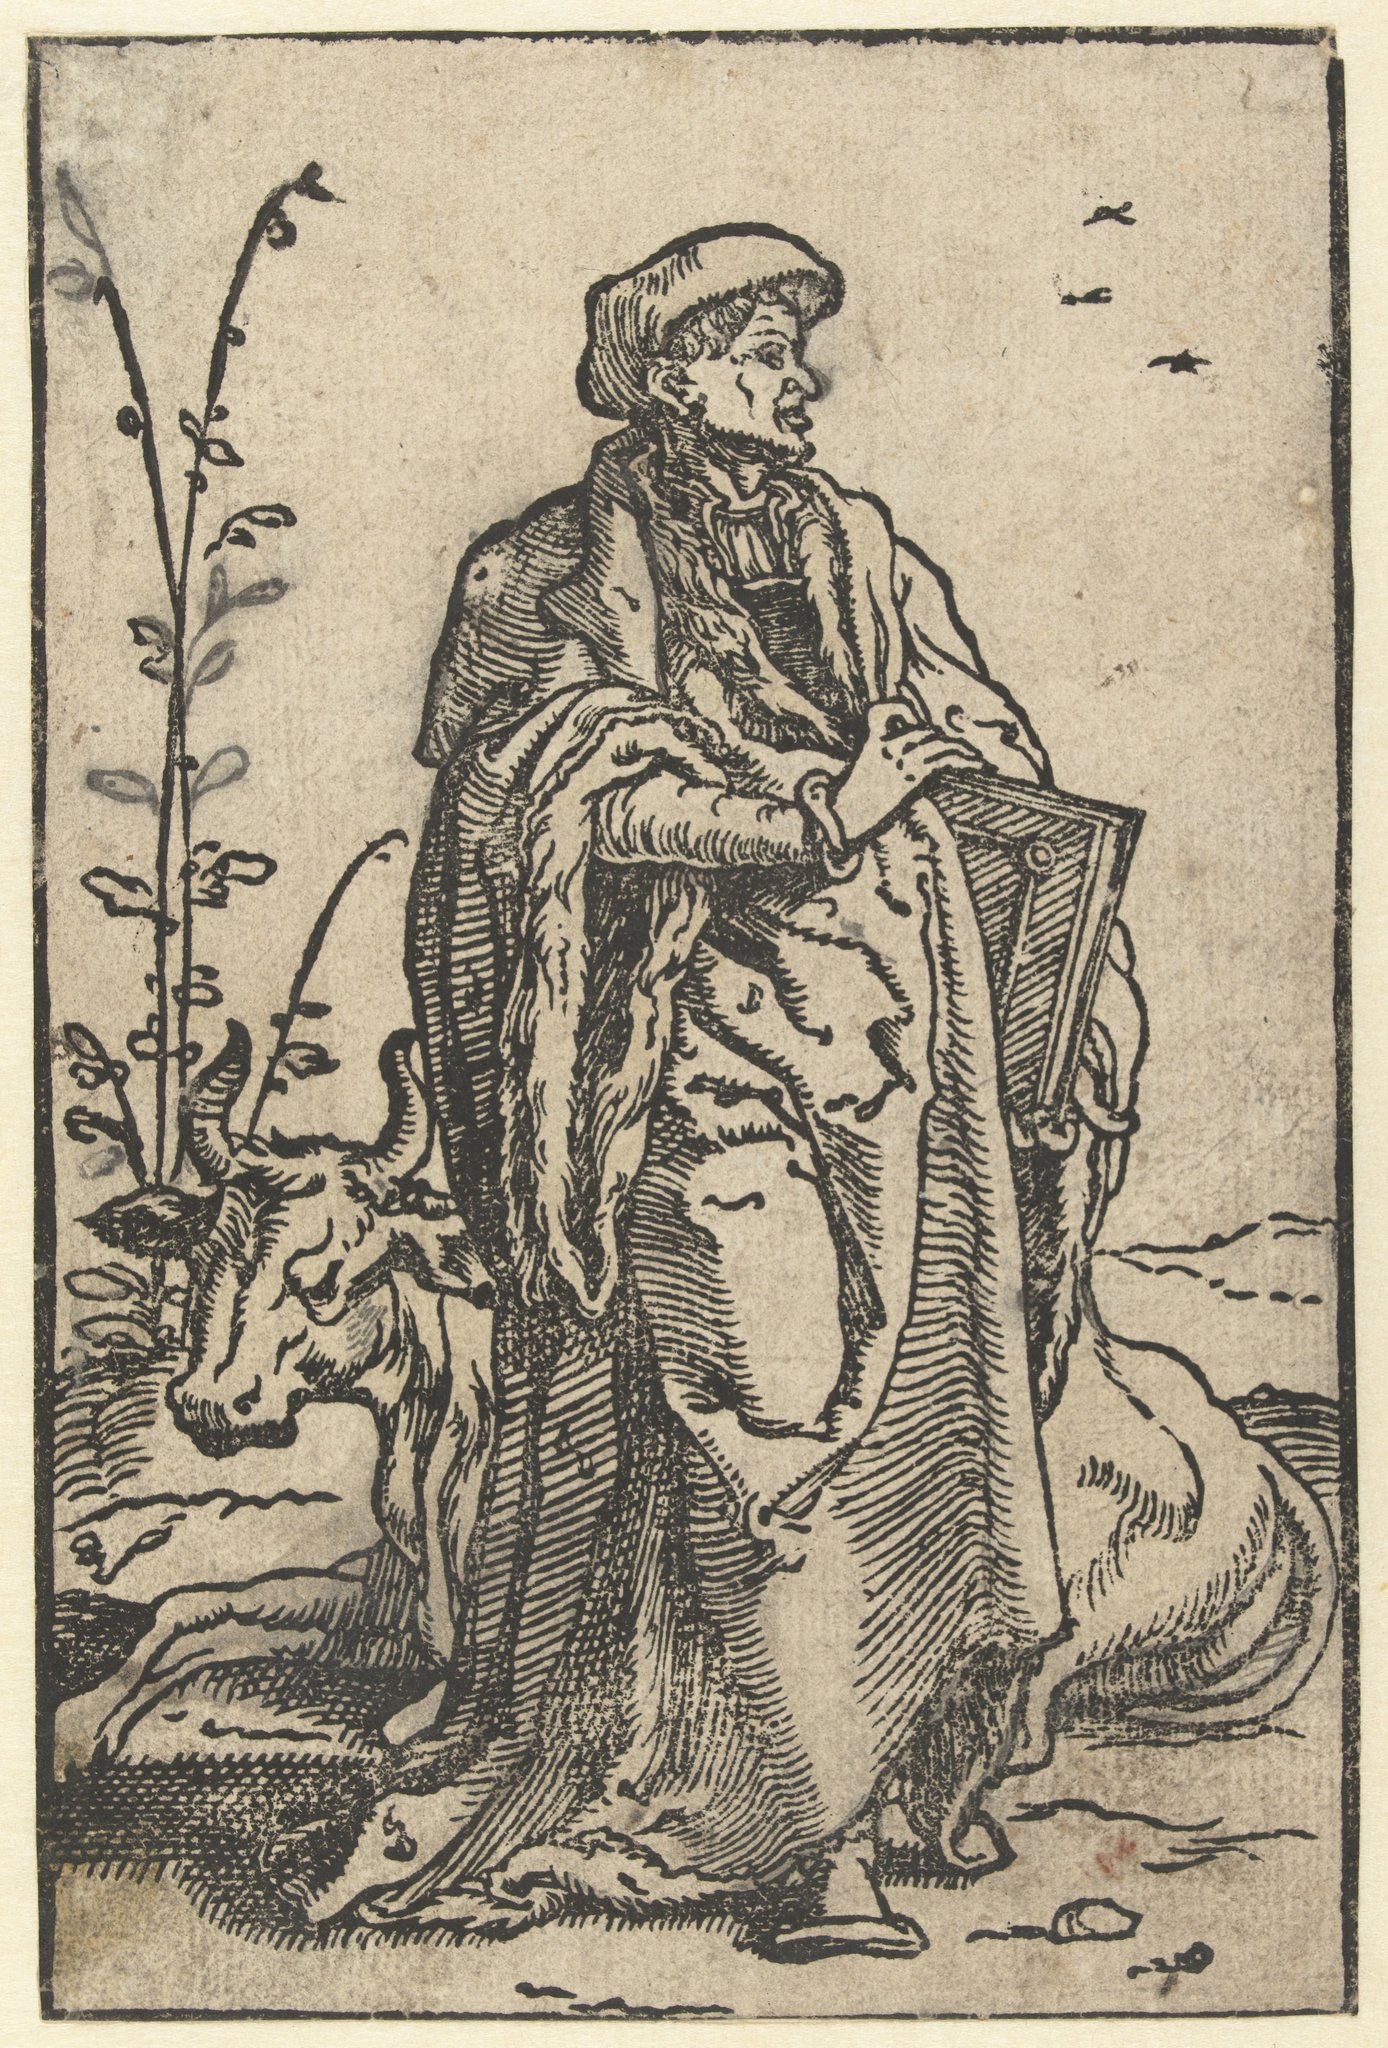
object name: print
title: Evangelist Lucas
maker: jan swart van groningen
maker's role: draughtsman, painter, print maker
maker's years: 1500-1562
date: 1510-1558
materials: paper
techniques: pen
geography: low countries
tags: luke the evangelist; possible attributes: book, (winged) ox, portrait of the virgin, surgical instruments, painter's utensils, scroll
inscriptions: collector's mark: Lugt 240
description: Lucas, staand en naar rechts gedraaid, met boek in hand. Os ligt achter hem.